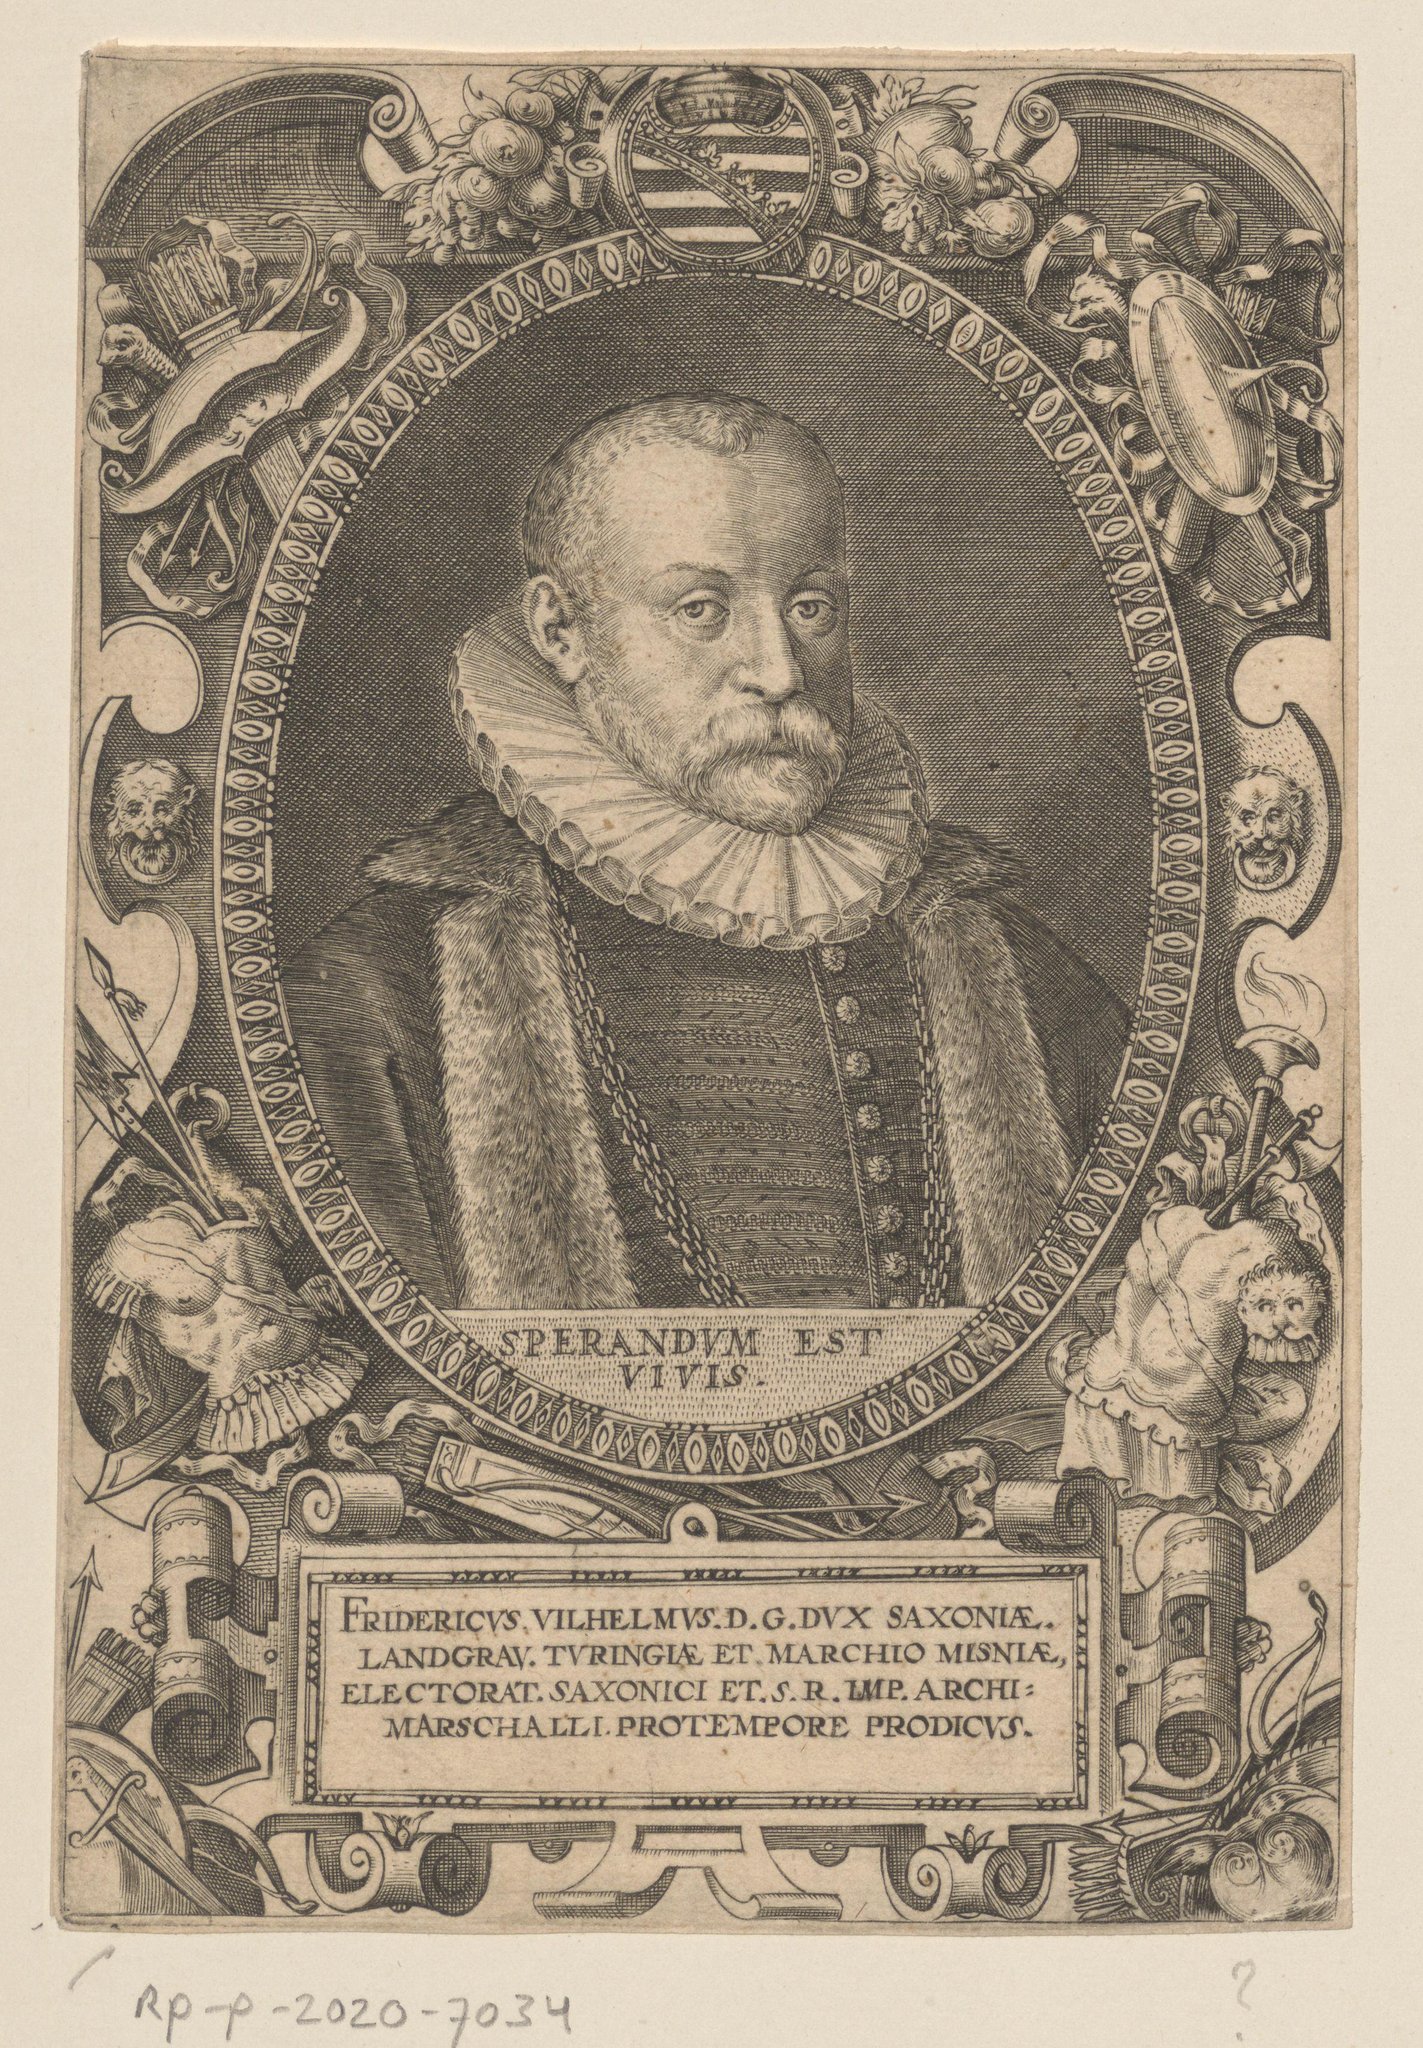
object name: print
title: Portretten van bekende personen uit de zestiende eeuw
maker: dominicus custos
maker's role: print maker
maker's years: 1560-1615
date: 1600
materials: paper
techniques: engraving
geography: augsburg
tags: archer's weapons: bow and arrow, historical persons, ornament ~ cartouche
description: Prent waarschijnlijk uit: Custos, Dominicus. Atrium heroicum caesarum (...). Augsburg: Dominicus Custos, 1600, dl. 1. De serie werd in vier delen uitgegeven tussen 1600 en 1604.